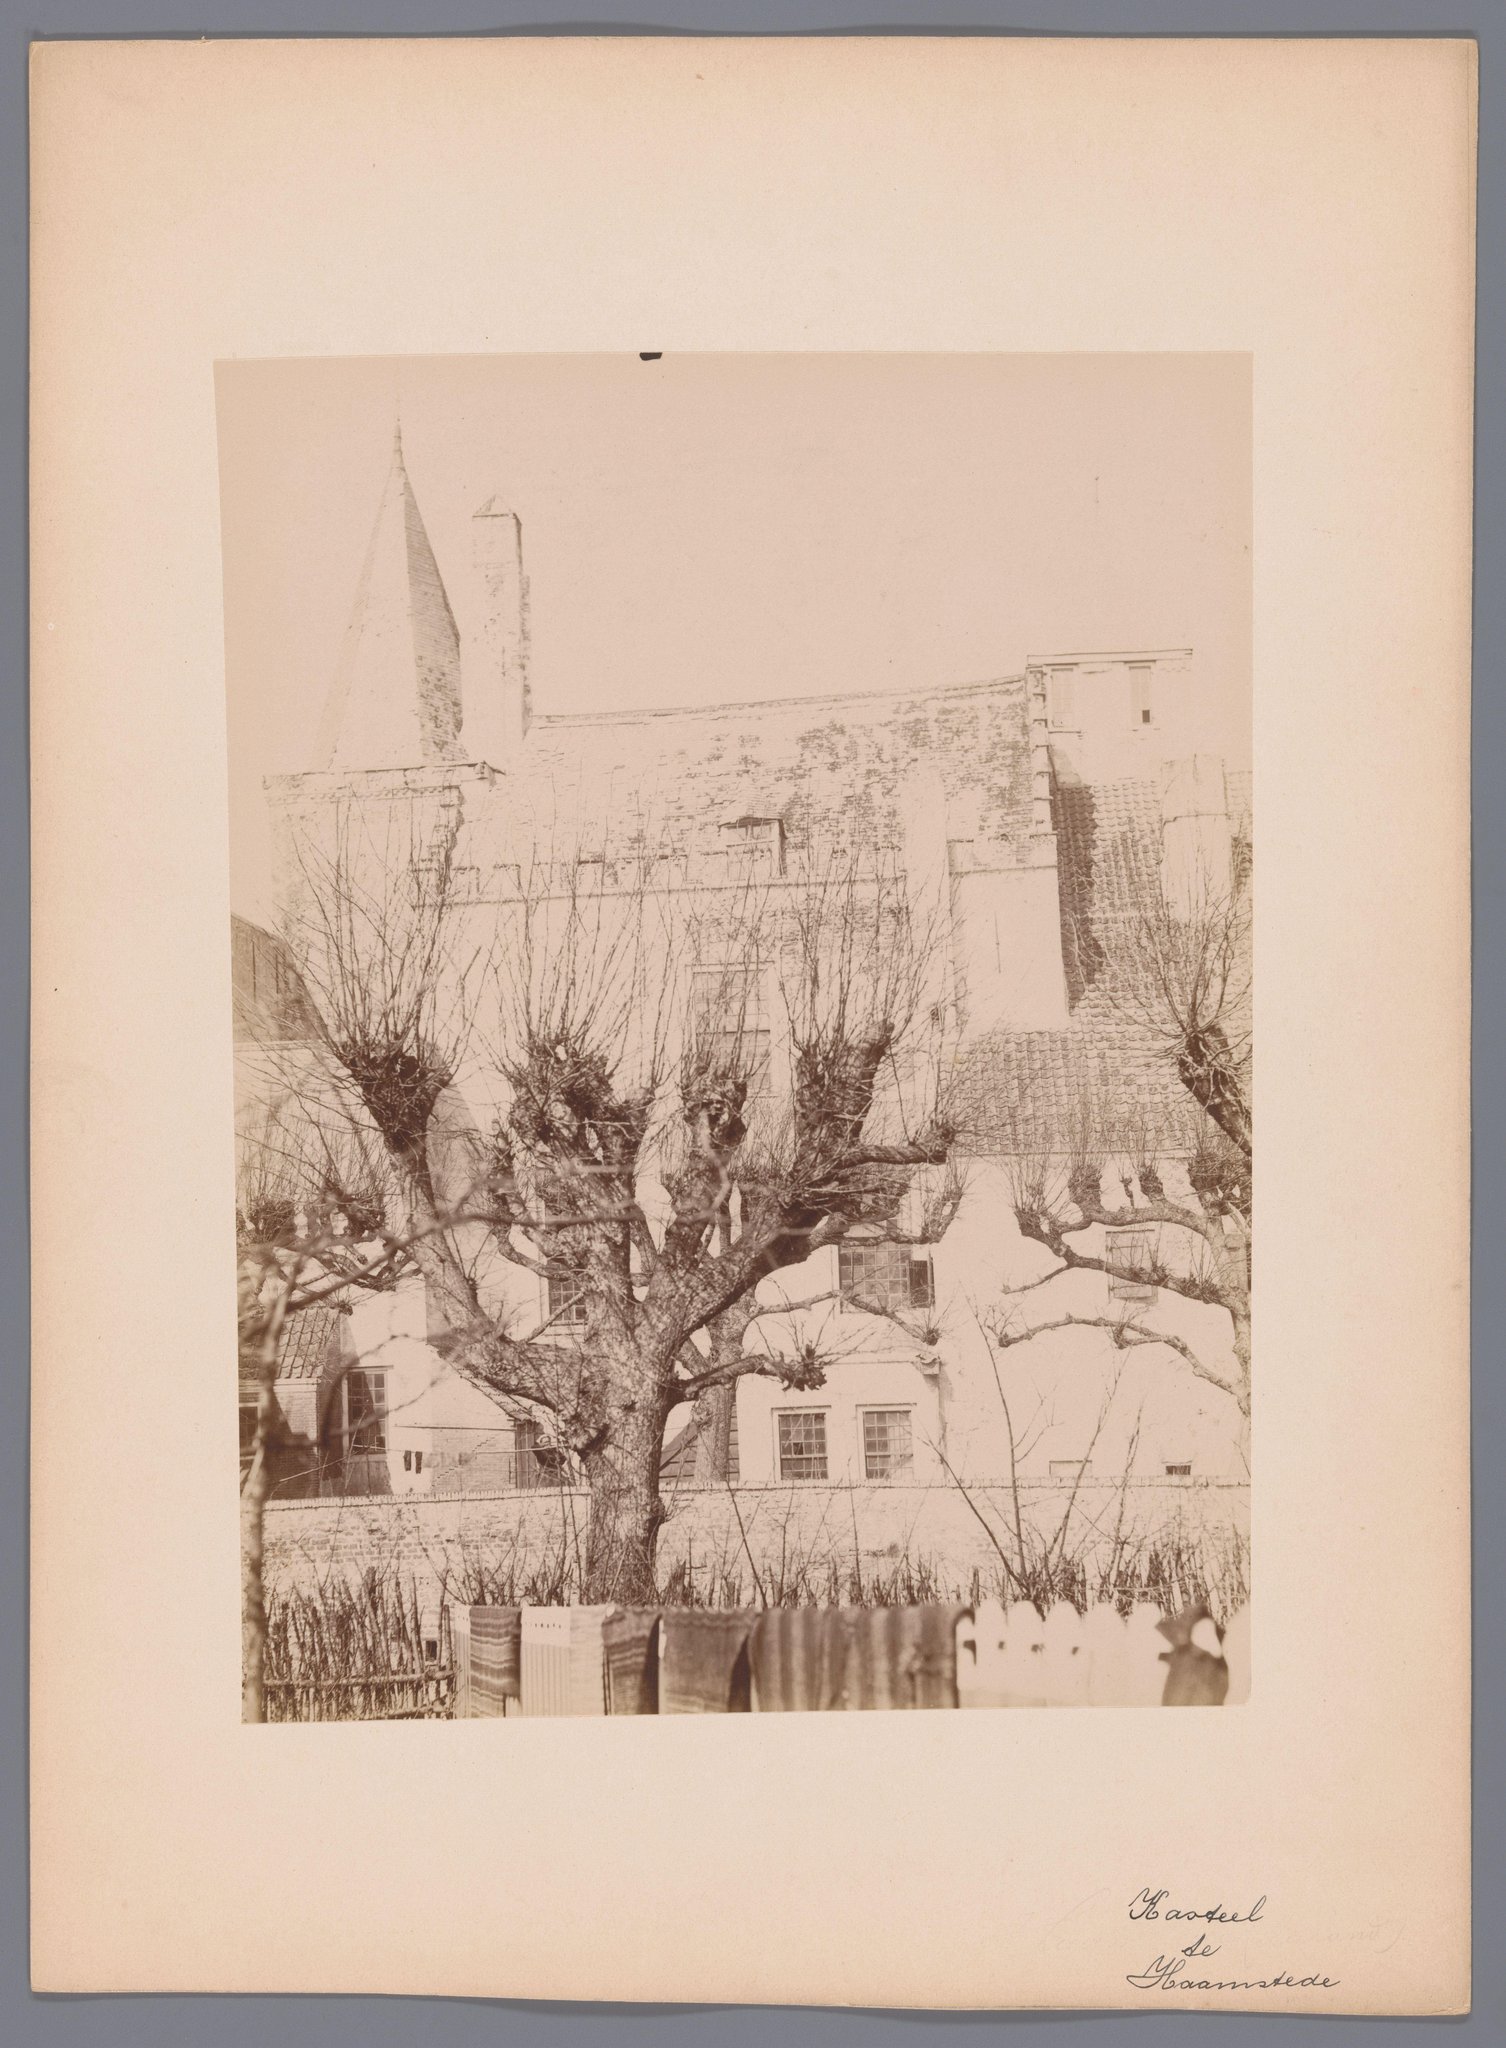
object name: photograph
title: Gezicht op Slot Haamstede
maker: anoniem (monumentenzorg)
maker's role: fotograaf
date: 1890-1920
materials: cardboard, photographic support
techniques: albumen print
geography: haamstede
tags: castle, slot haamstede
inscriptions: annotation: ‘Kasteel te Haamstede’, annotation: ‘Kasteel Haamstede/ Zeeland’